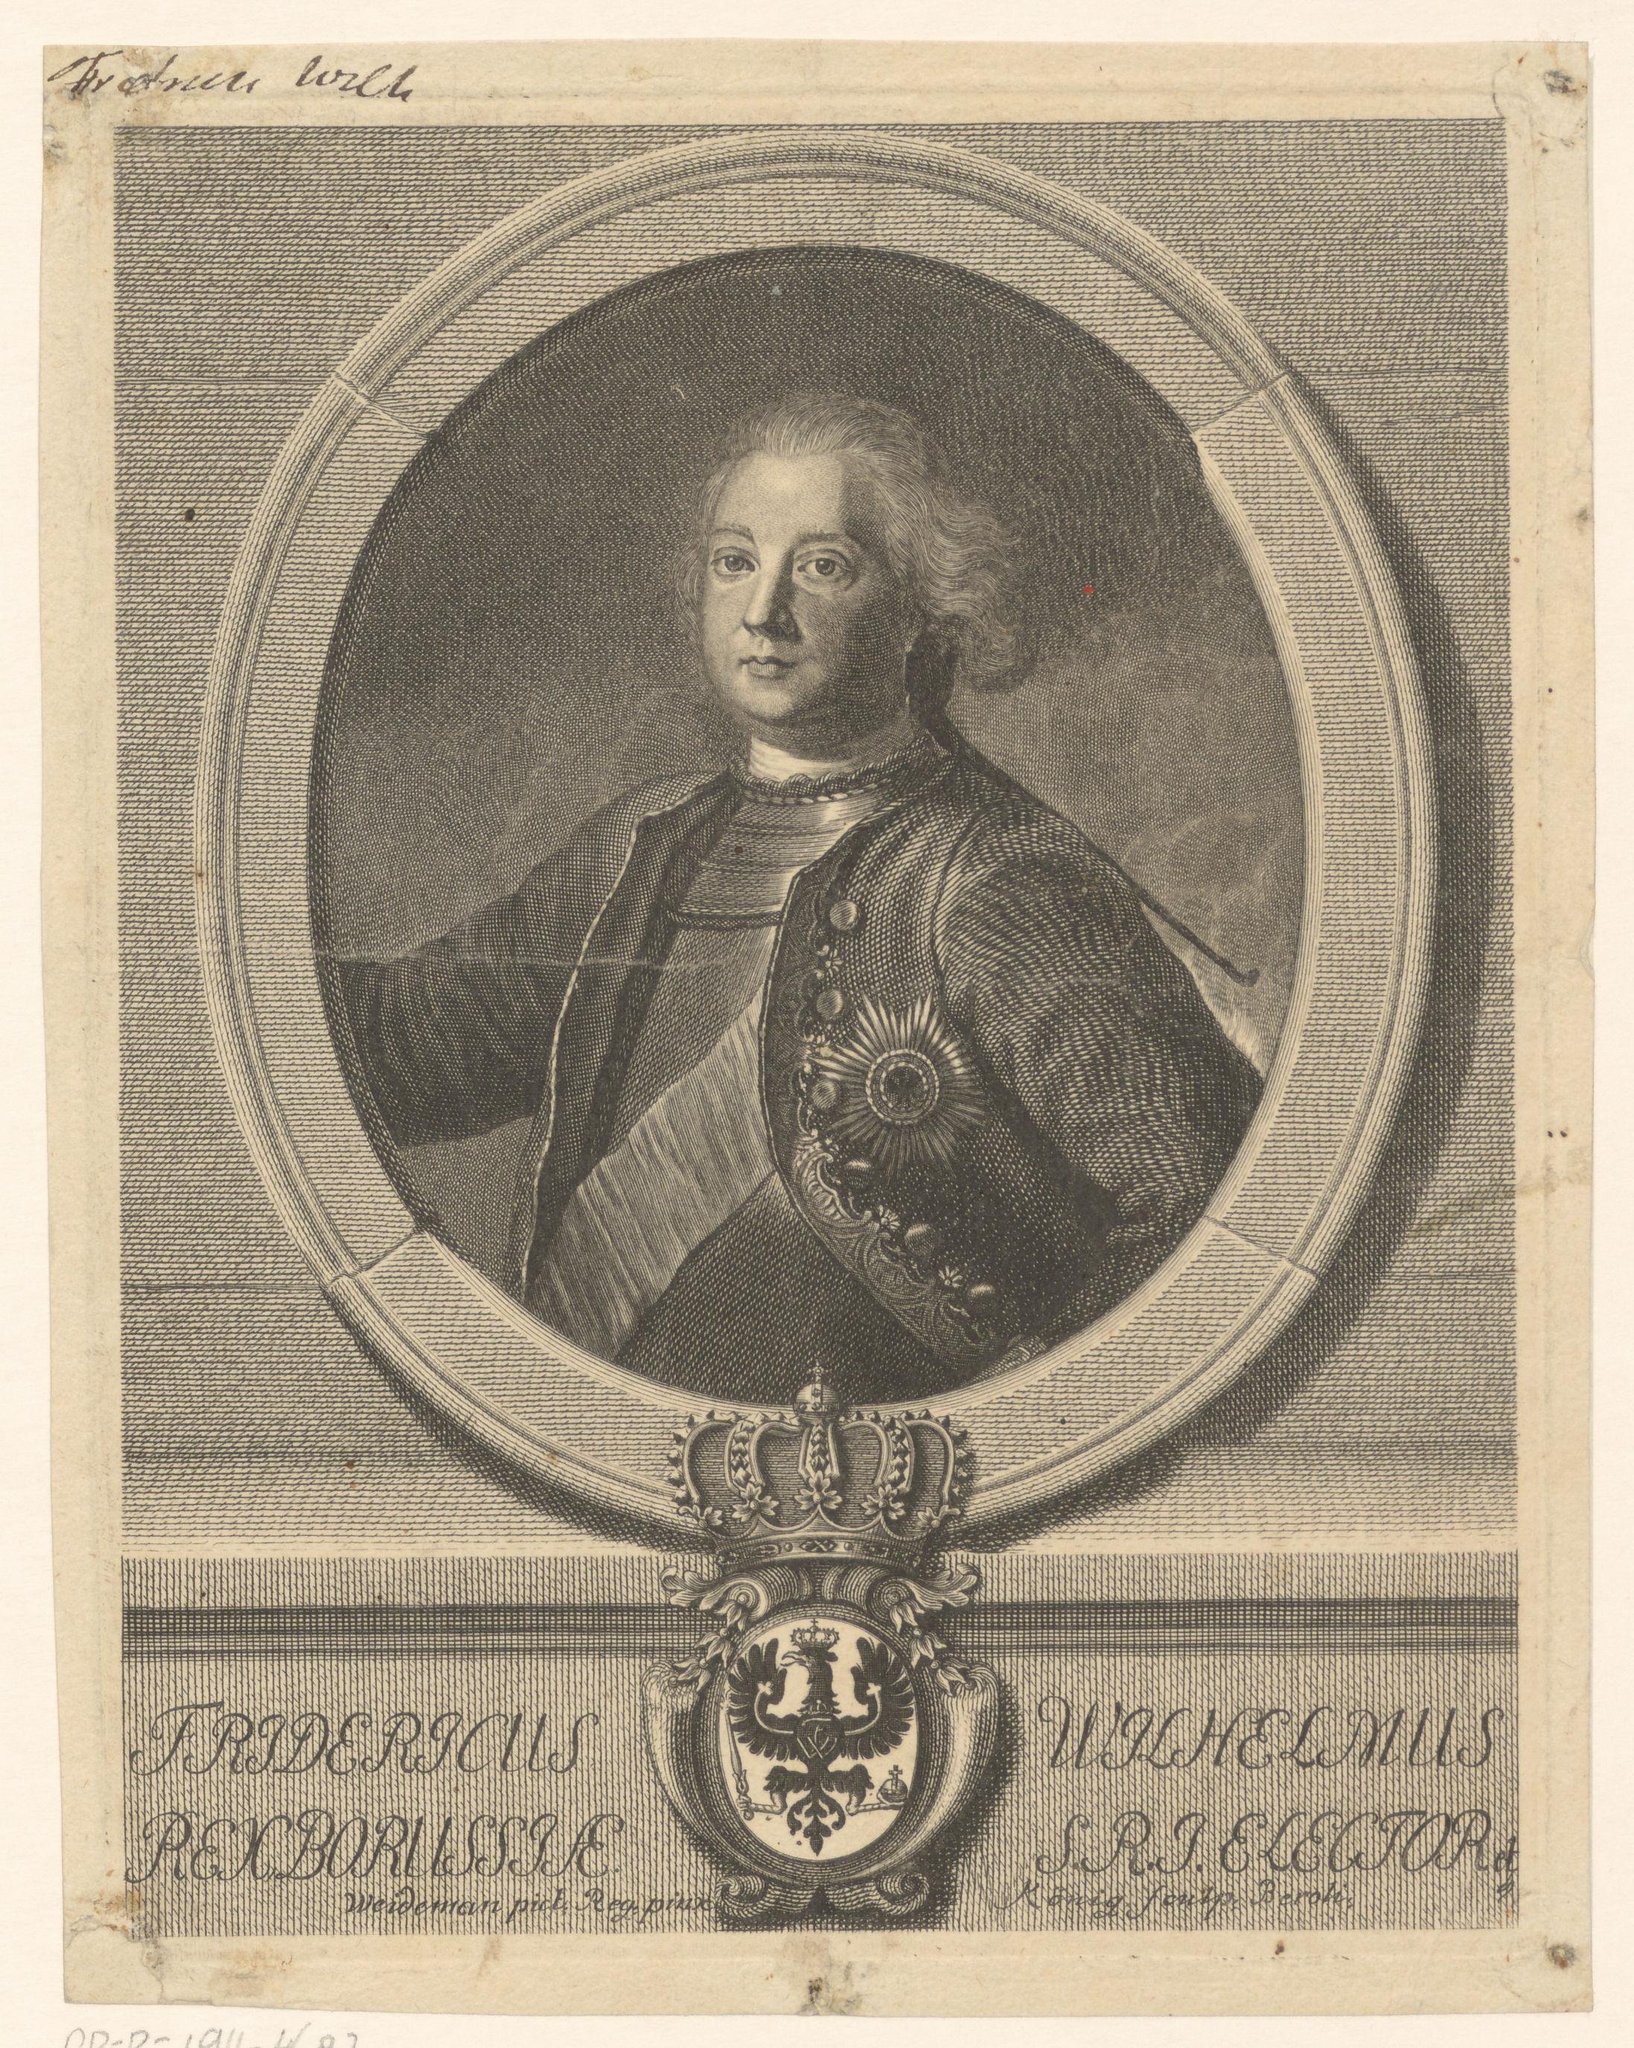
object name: print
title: Portret van Frederik Willem II, koning van Pruisen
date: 1755-1773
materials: paper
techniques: engraving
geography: berlin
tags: berlin, frederik willem ii (koning van pruisen), historical persons, king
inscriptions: collector's mark: Lugt 2228